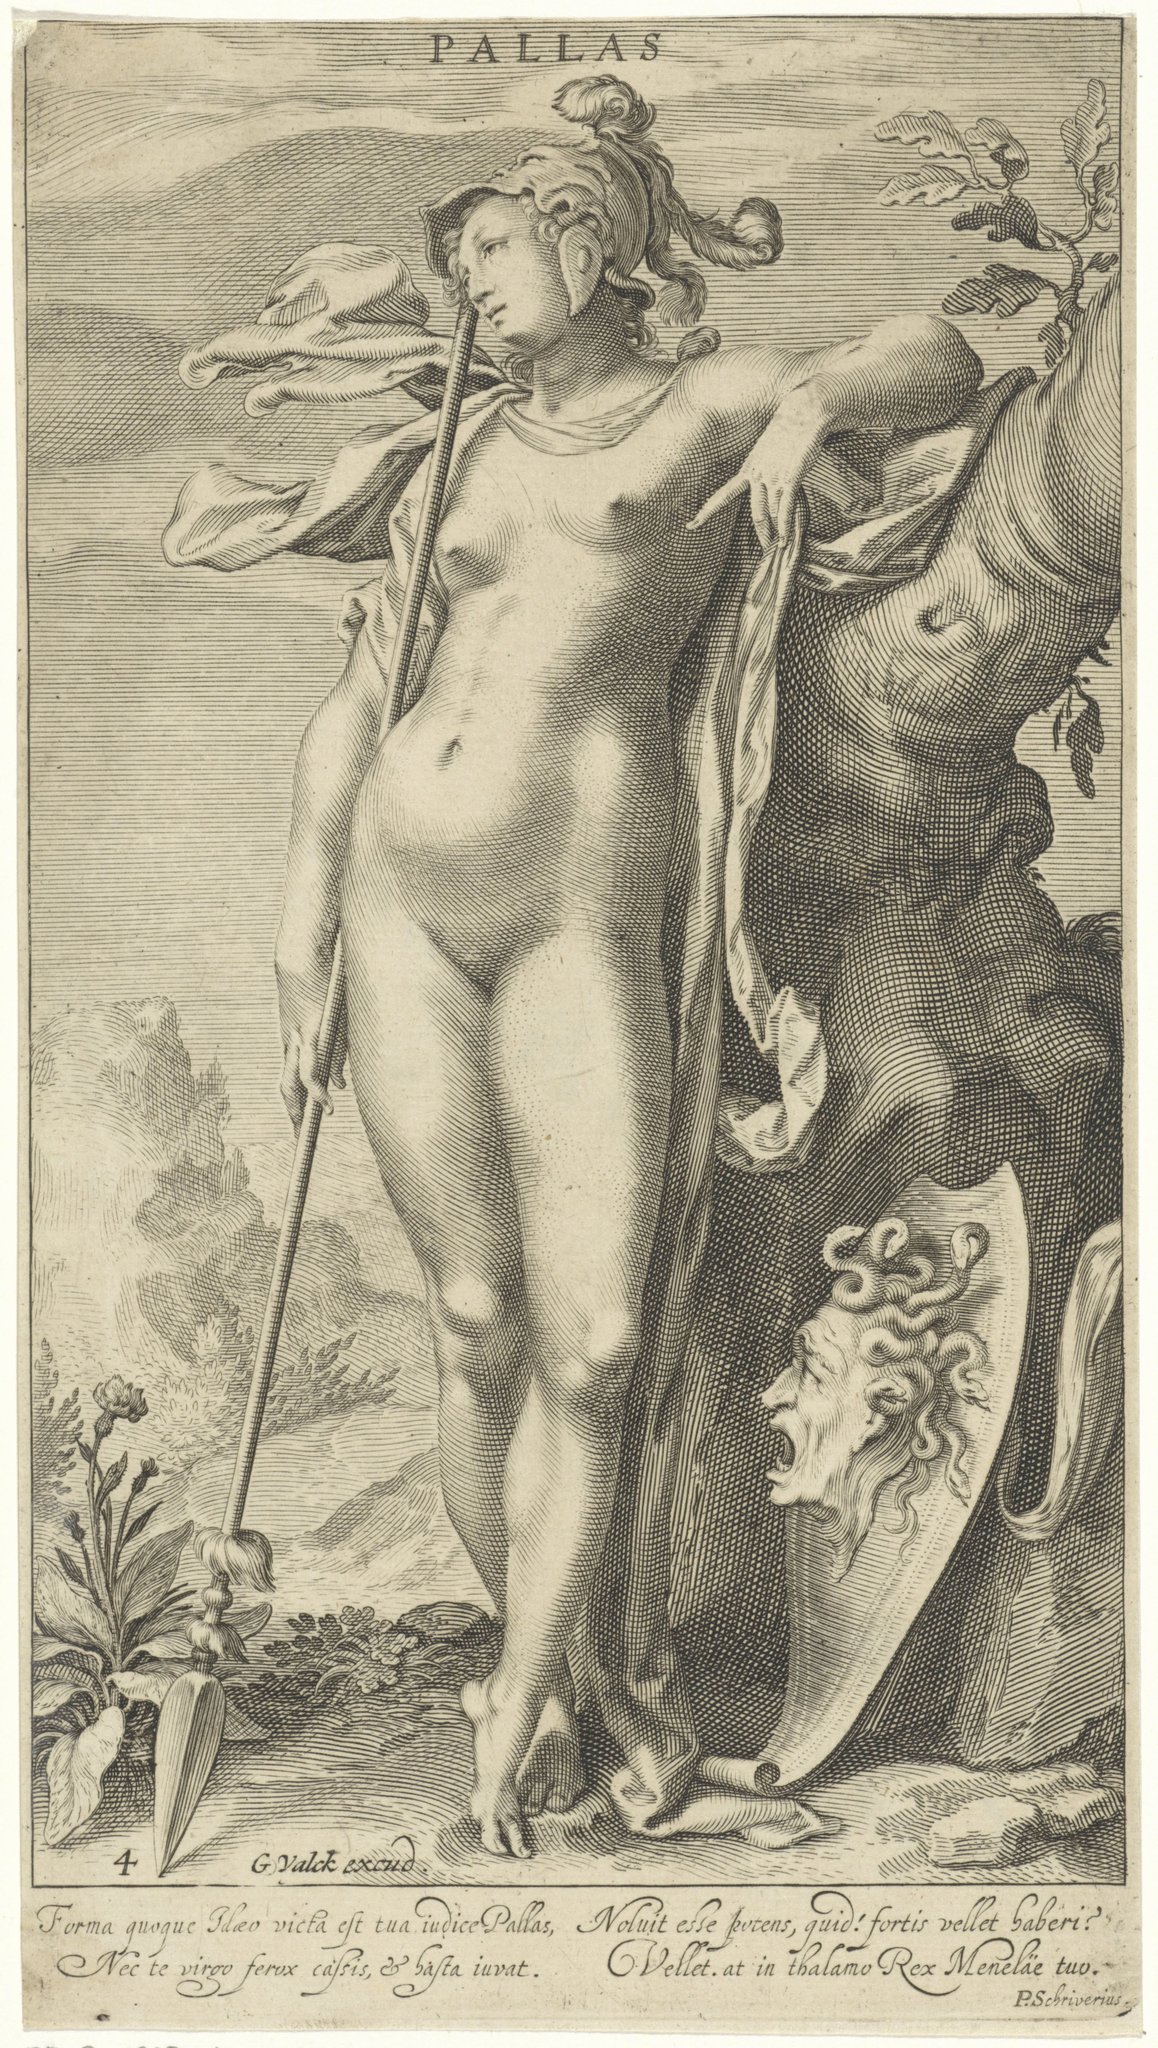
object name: print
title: Oordeel van Paris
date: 1670-1726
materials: paper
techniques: engraving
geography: leiden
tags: helmet, the judgement of paris (mercury present), (story of) minerva (pallas, athena), casting weapons: spear, aegis: shield with gorgon's head (attribute of minerva)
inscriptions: collector's mark: Lugt 2228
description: Minerva staat bij een boom. Ze draagt een helm en houdt een speer vast. Tegen de boom staat het schild met het hoofd van Medusa. Onder de voorstelling bevindt zich een vierregelige, Latijnse tekst met een beschrijving van Minerva's belofte aan Paris.